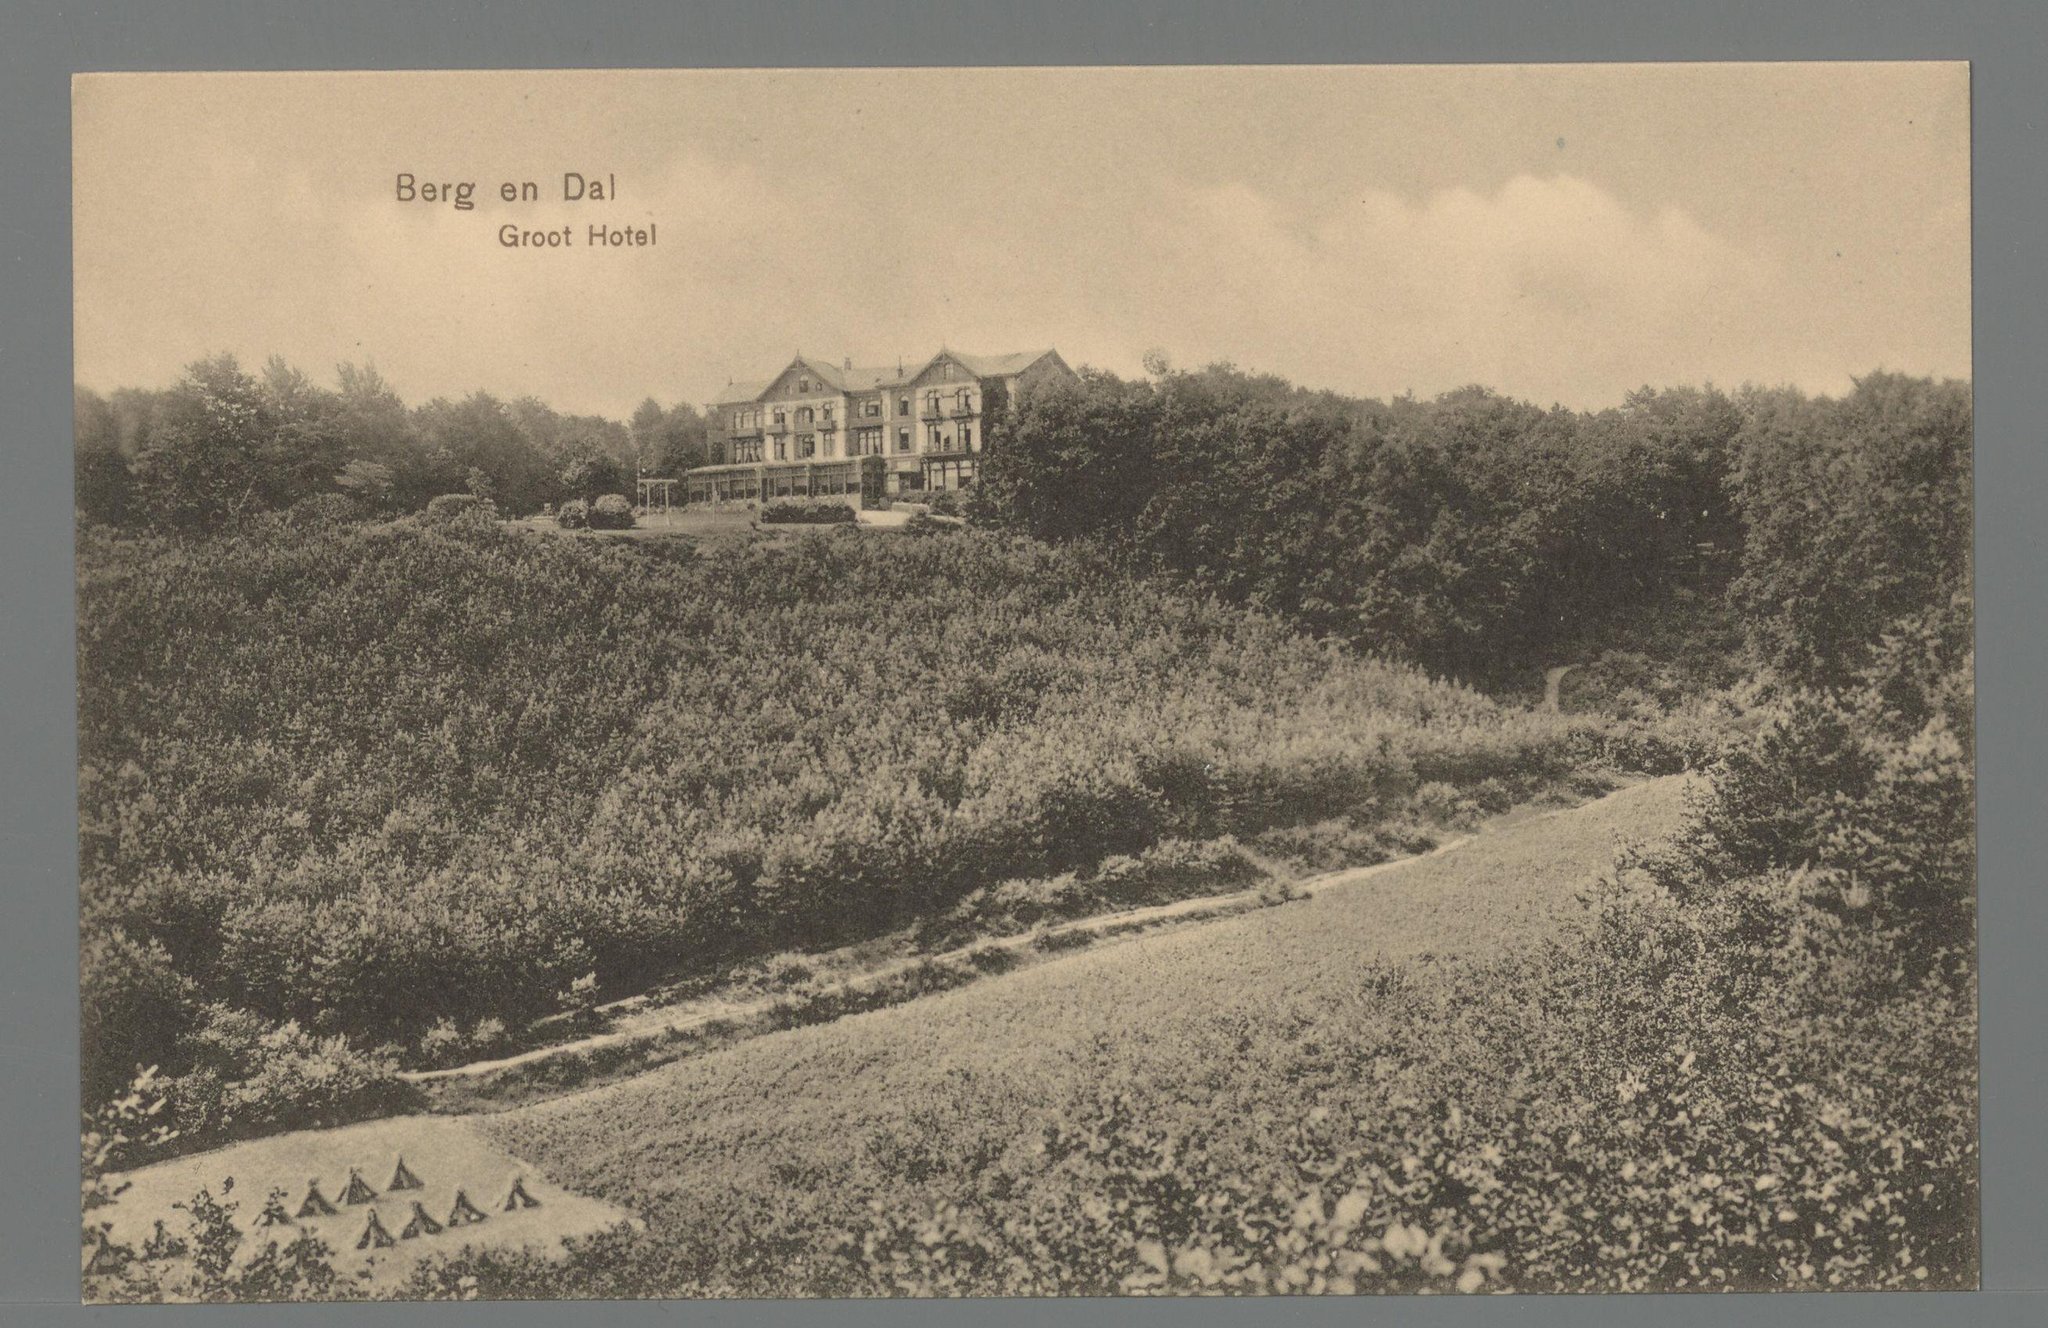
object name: photomechanical print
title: Berg en Dal. Groot Hotel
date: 1913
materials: cardboard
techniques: photograph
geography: nijmegen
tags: hotel, hostelry, inn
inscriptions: date